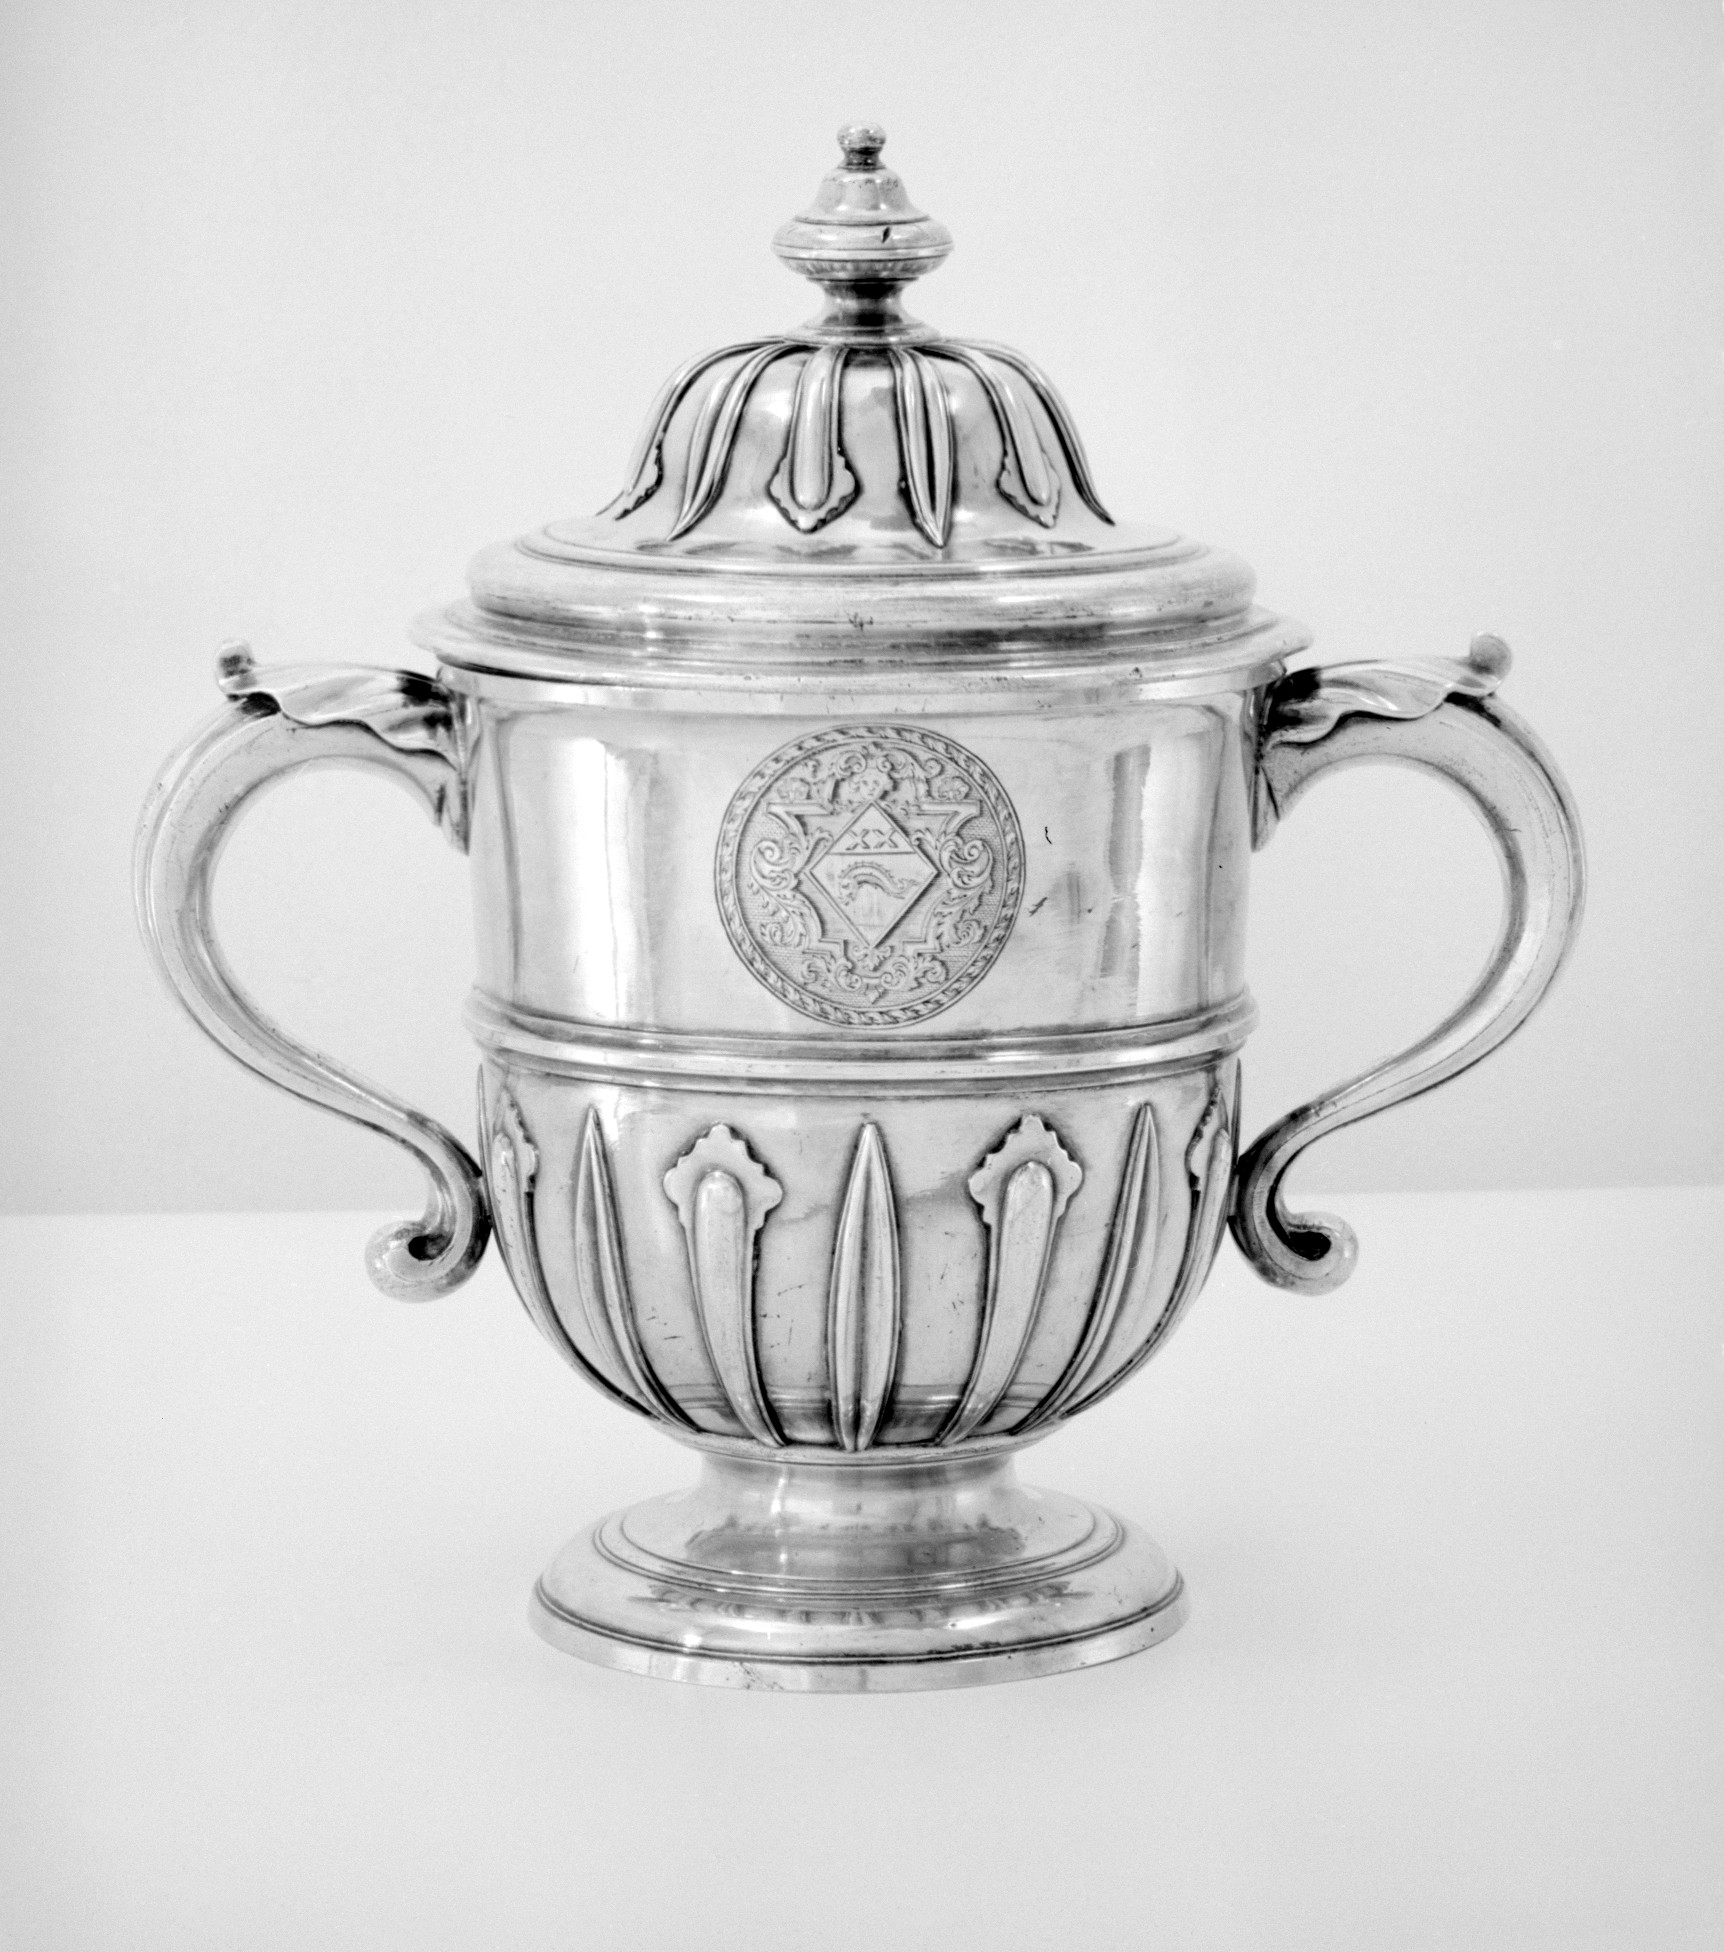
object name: cup with cover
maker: thomas folkingham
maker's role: maker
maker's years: 1703-1729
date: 1711-1712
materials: silver gilt